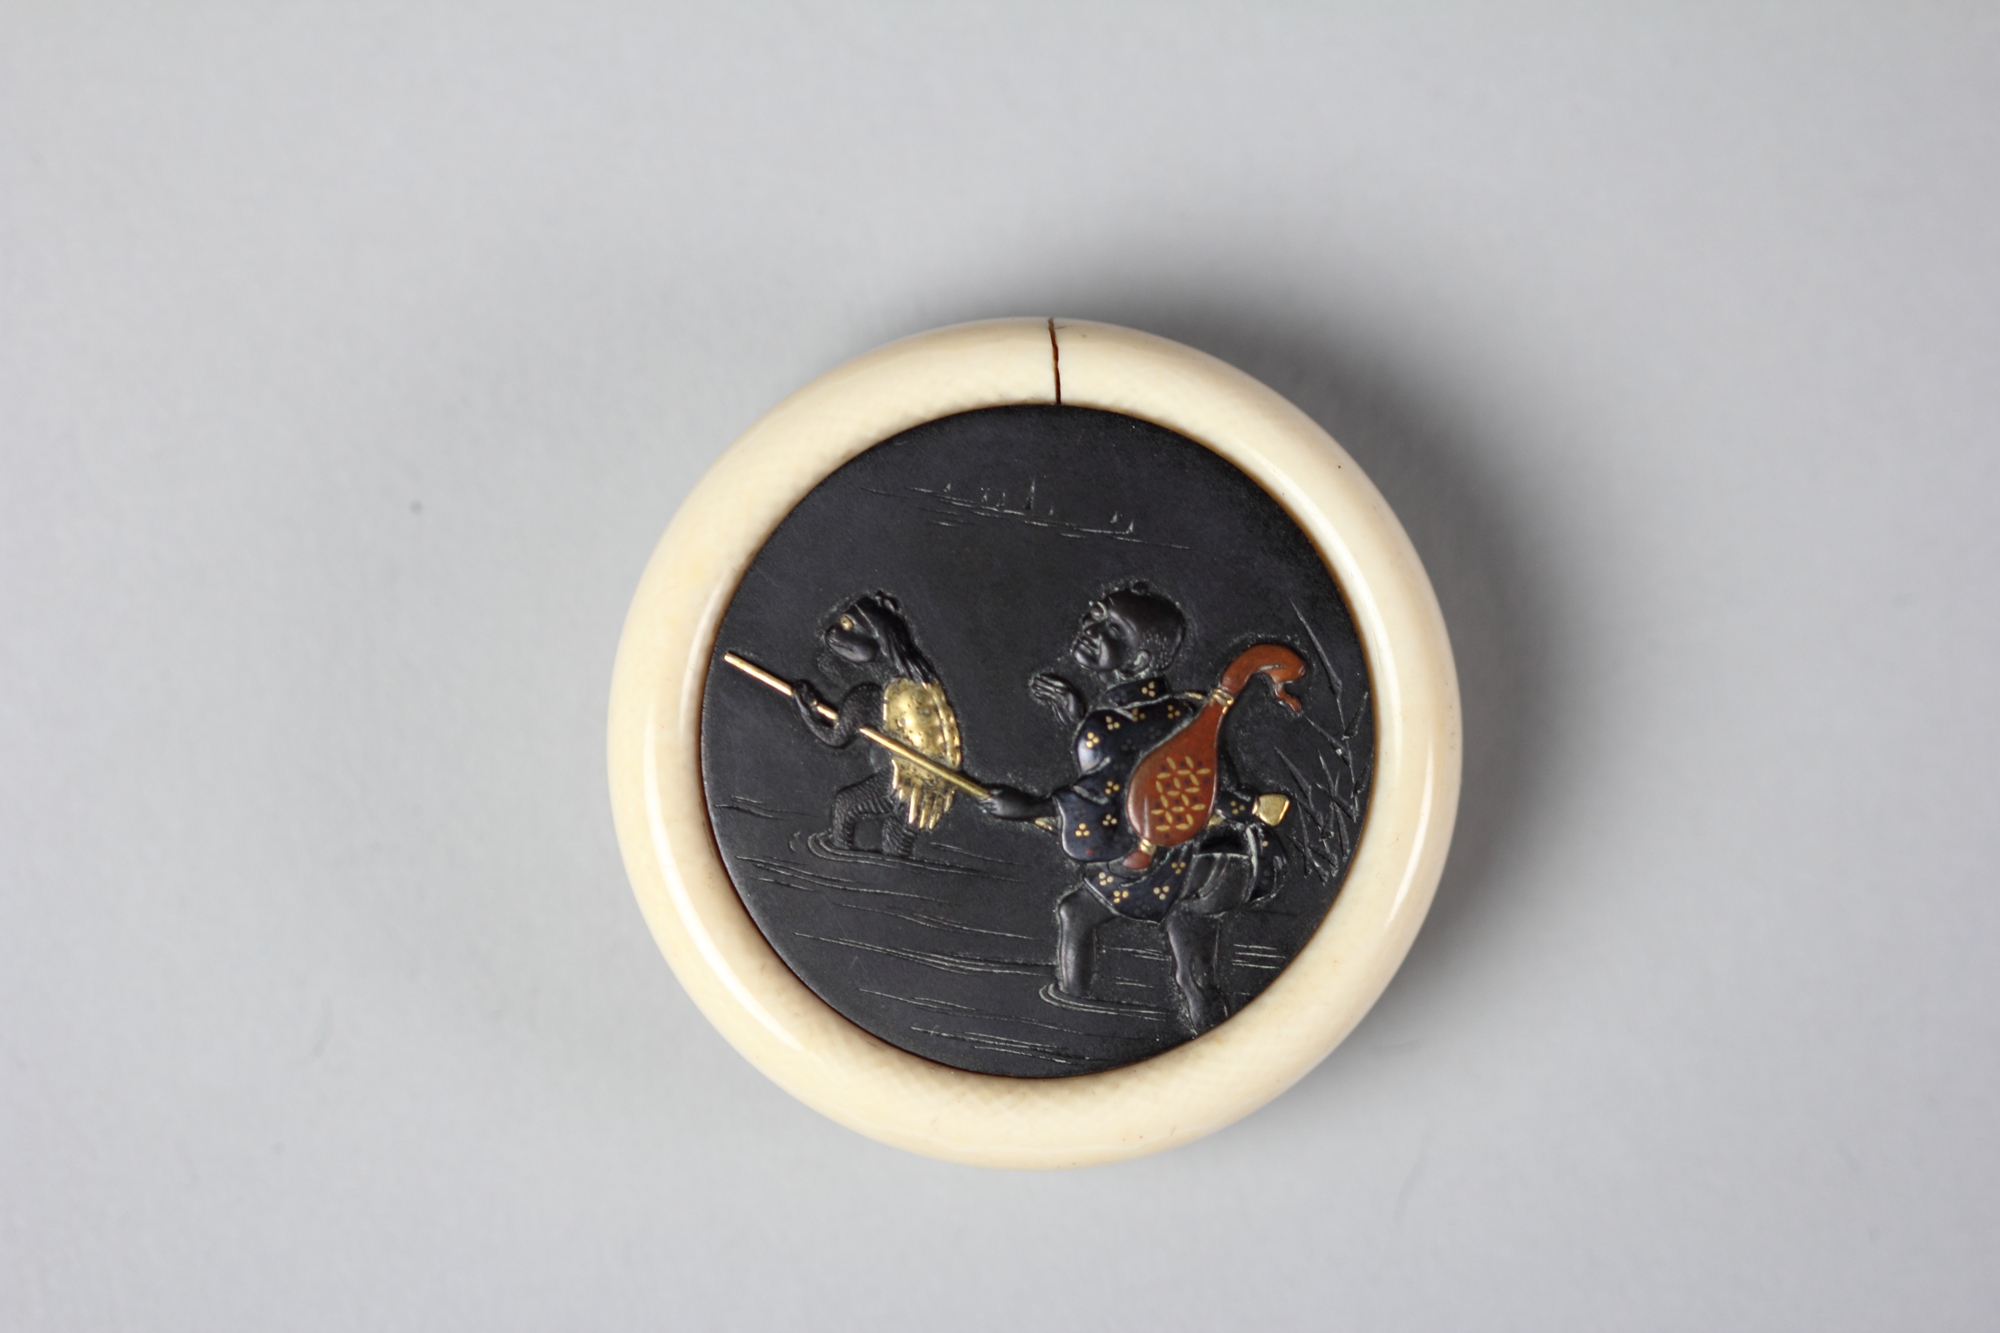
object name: netsuke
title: Kappa Leading Blind Man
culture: japanese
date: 1801-1900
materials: bronze, gold, ivory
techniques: inlay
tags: men